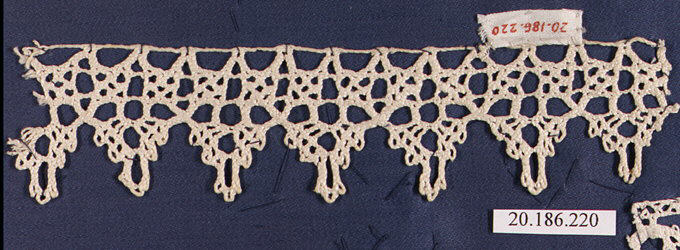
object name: edging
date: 1501-1600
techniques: lace